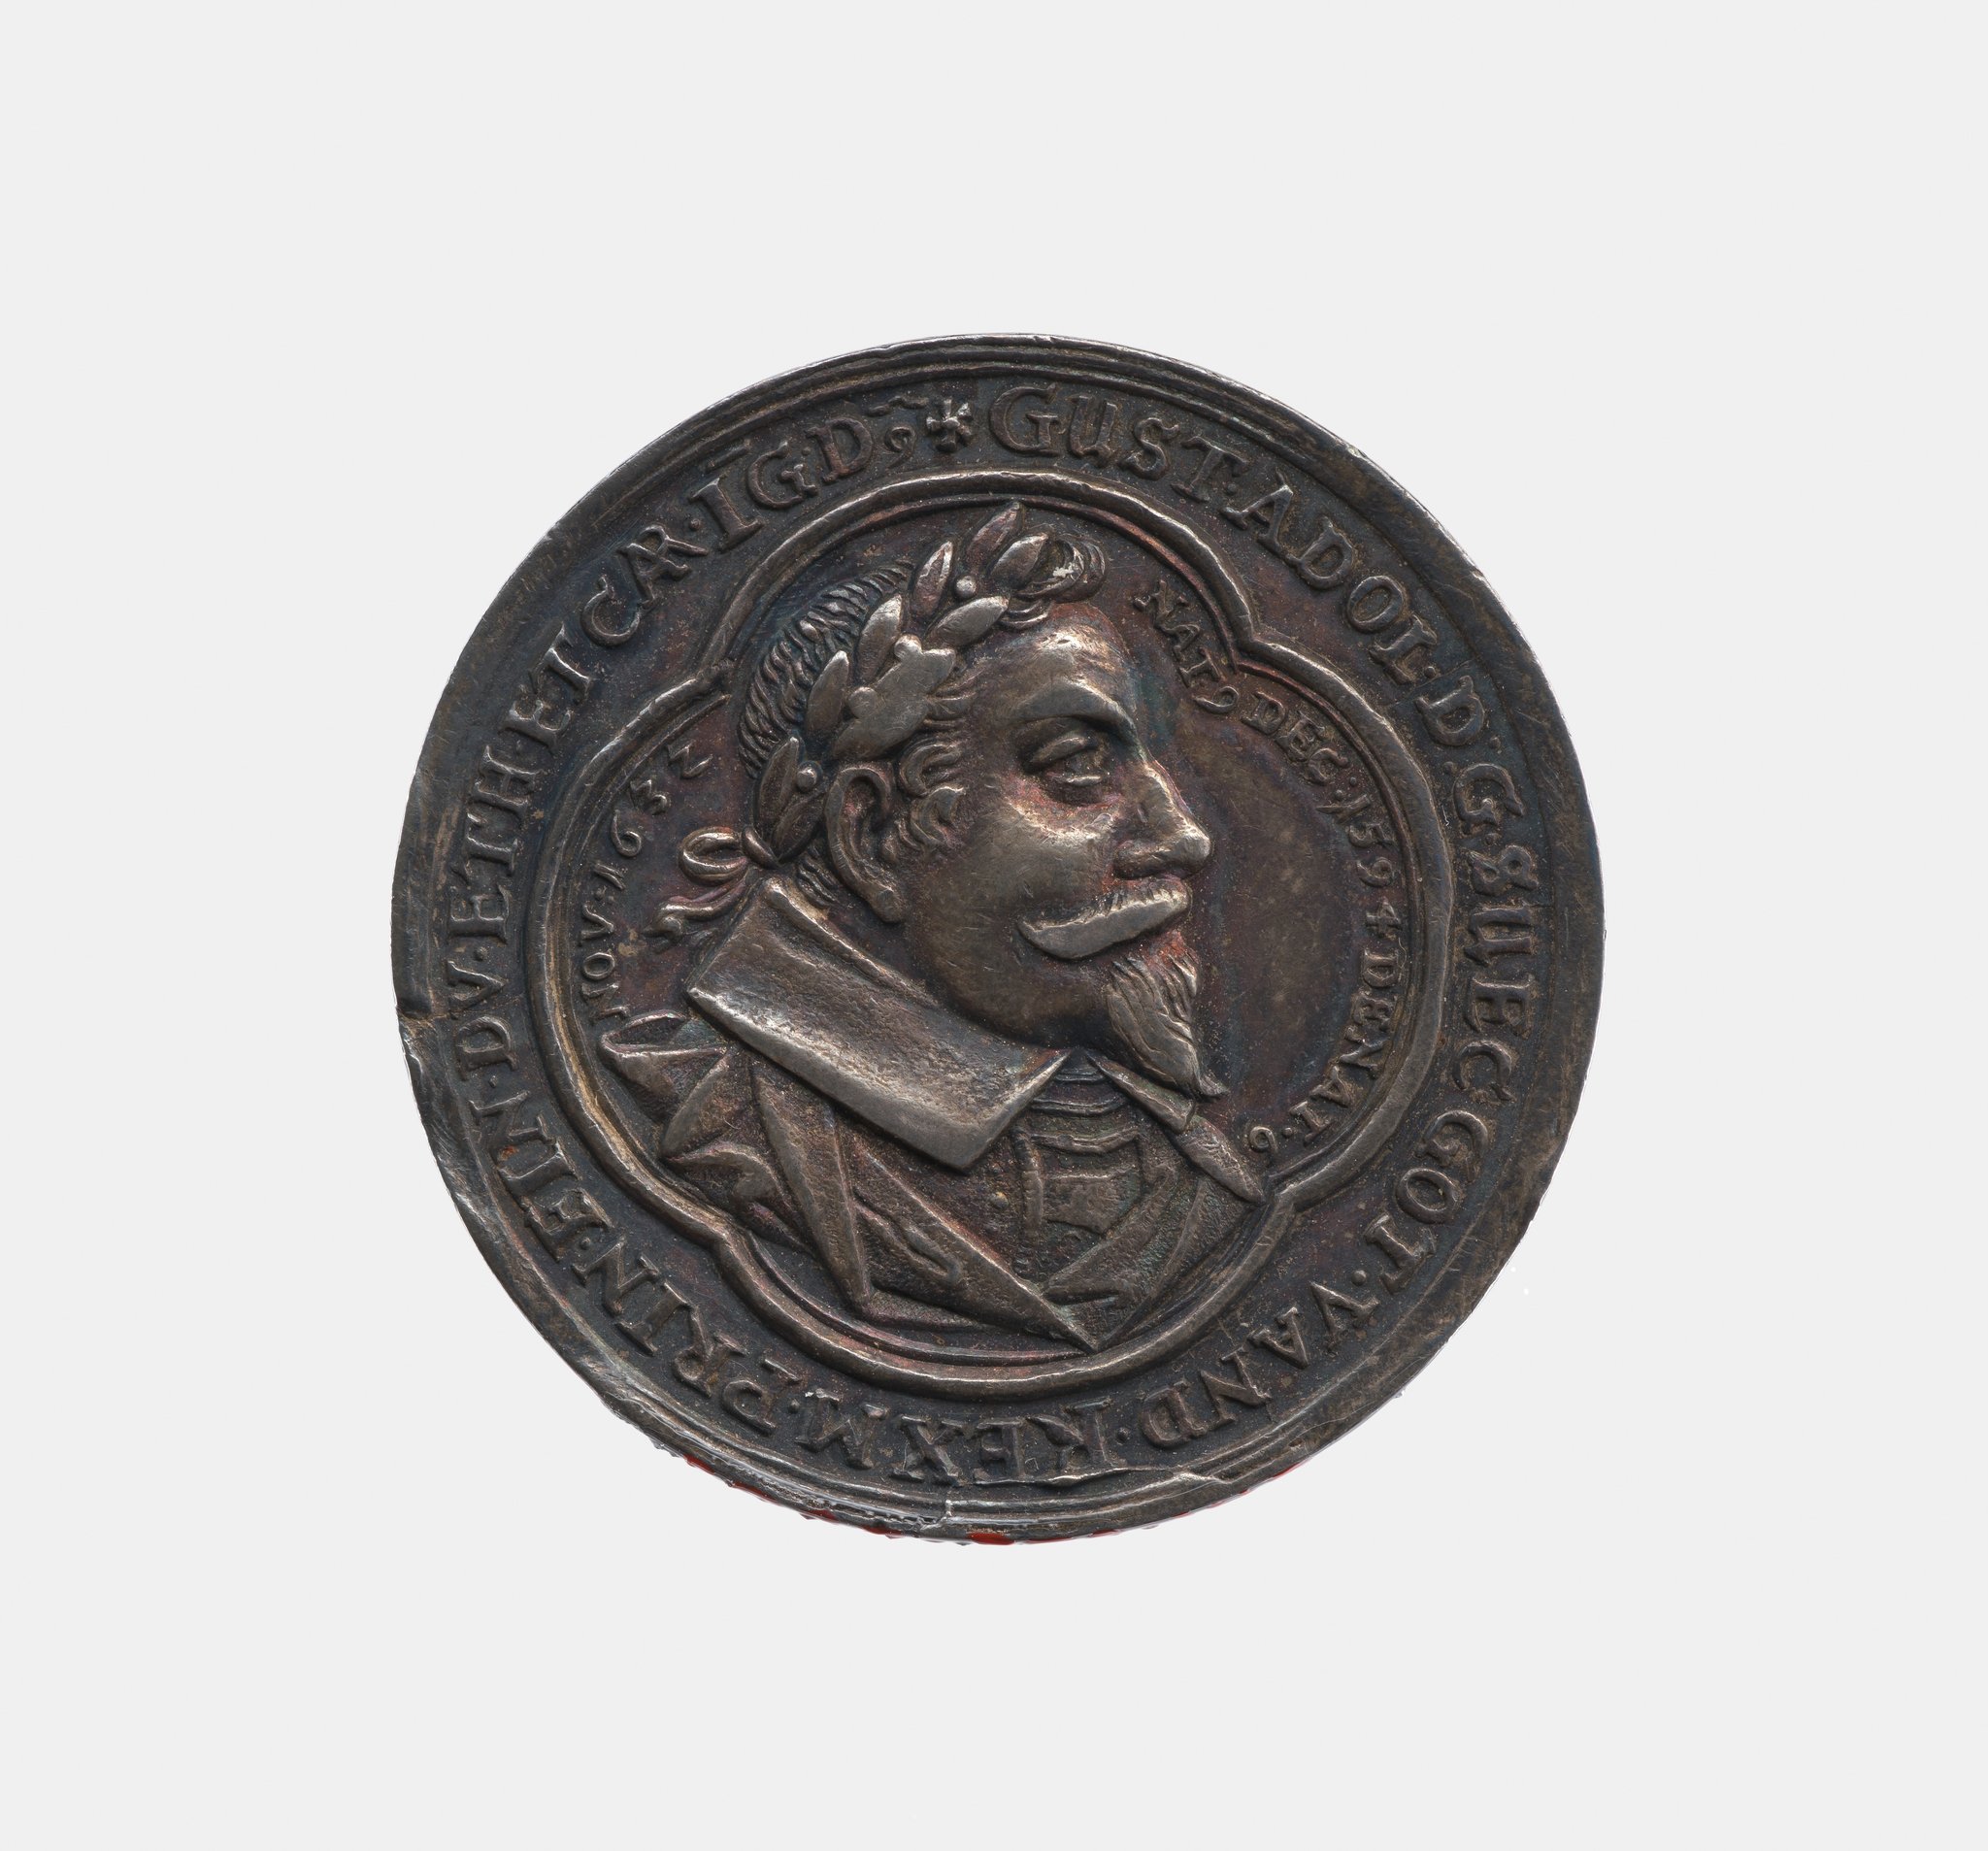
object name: medal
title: Gustav II Adolf 1594-1632, King of Sweden 1611-32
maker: k. rull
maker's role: artist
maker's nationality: swedish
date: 1632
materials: silver